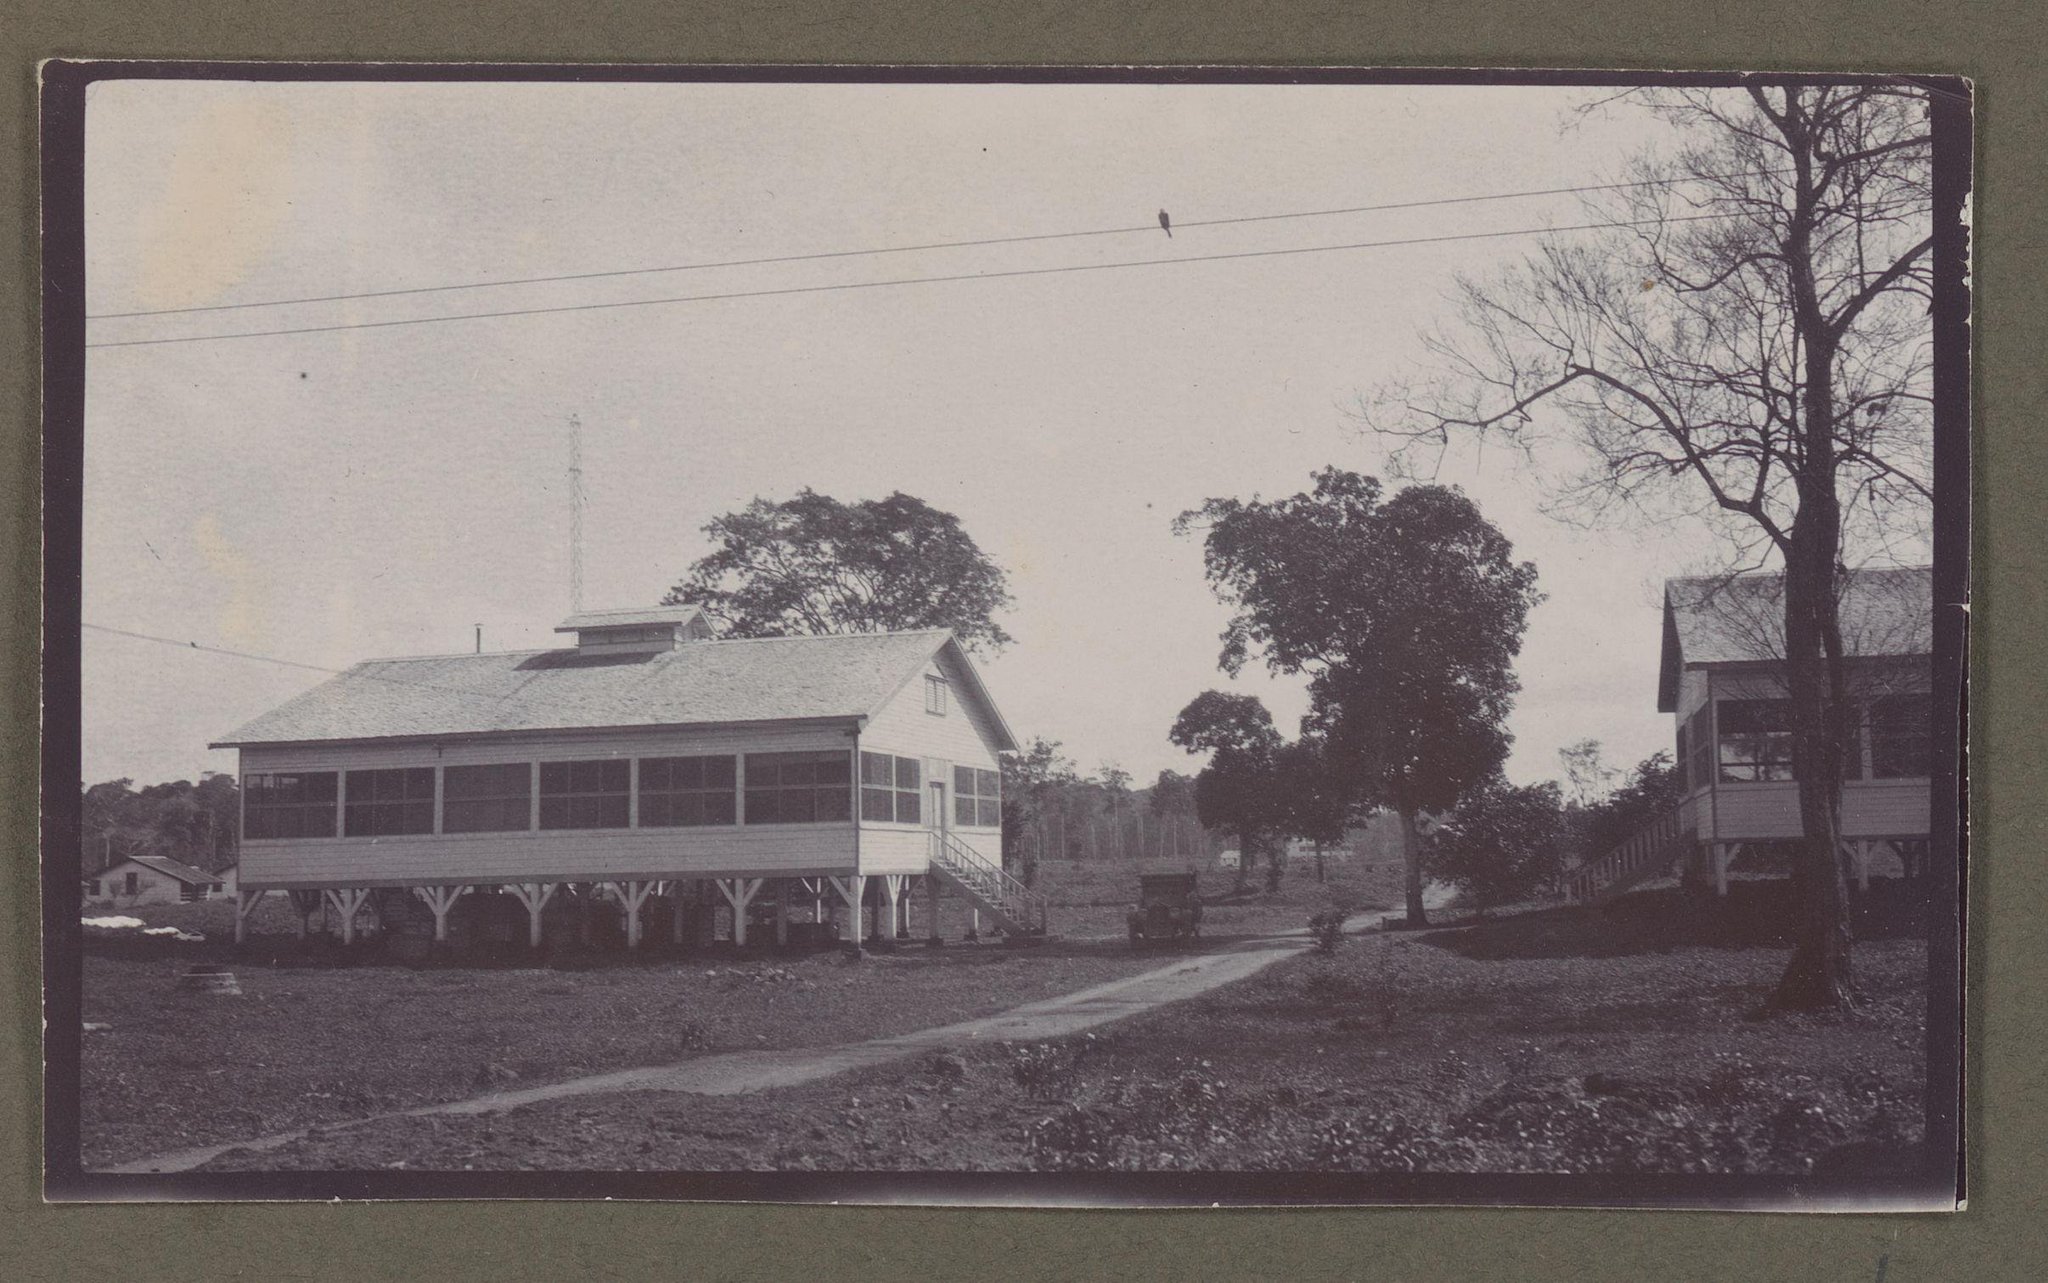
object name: photograph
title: Huis te Moengo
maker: Anonymous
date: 1925-1927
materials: photographic support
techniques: photography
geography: suriname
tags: jetten, familie, moengo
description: Familiefoto van het huis te Moengo. Foto op een bladzijde van een los albumblad. Onderdeel van het ensemble met foto's van de familie van ingenieur Jetten in de mijnbouwstad Moengo in Suriname.